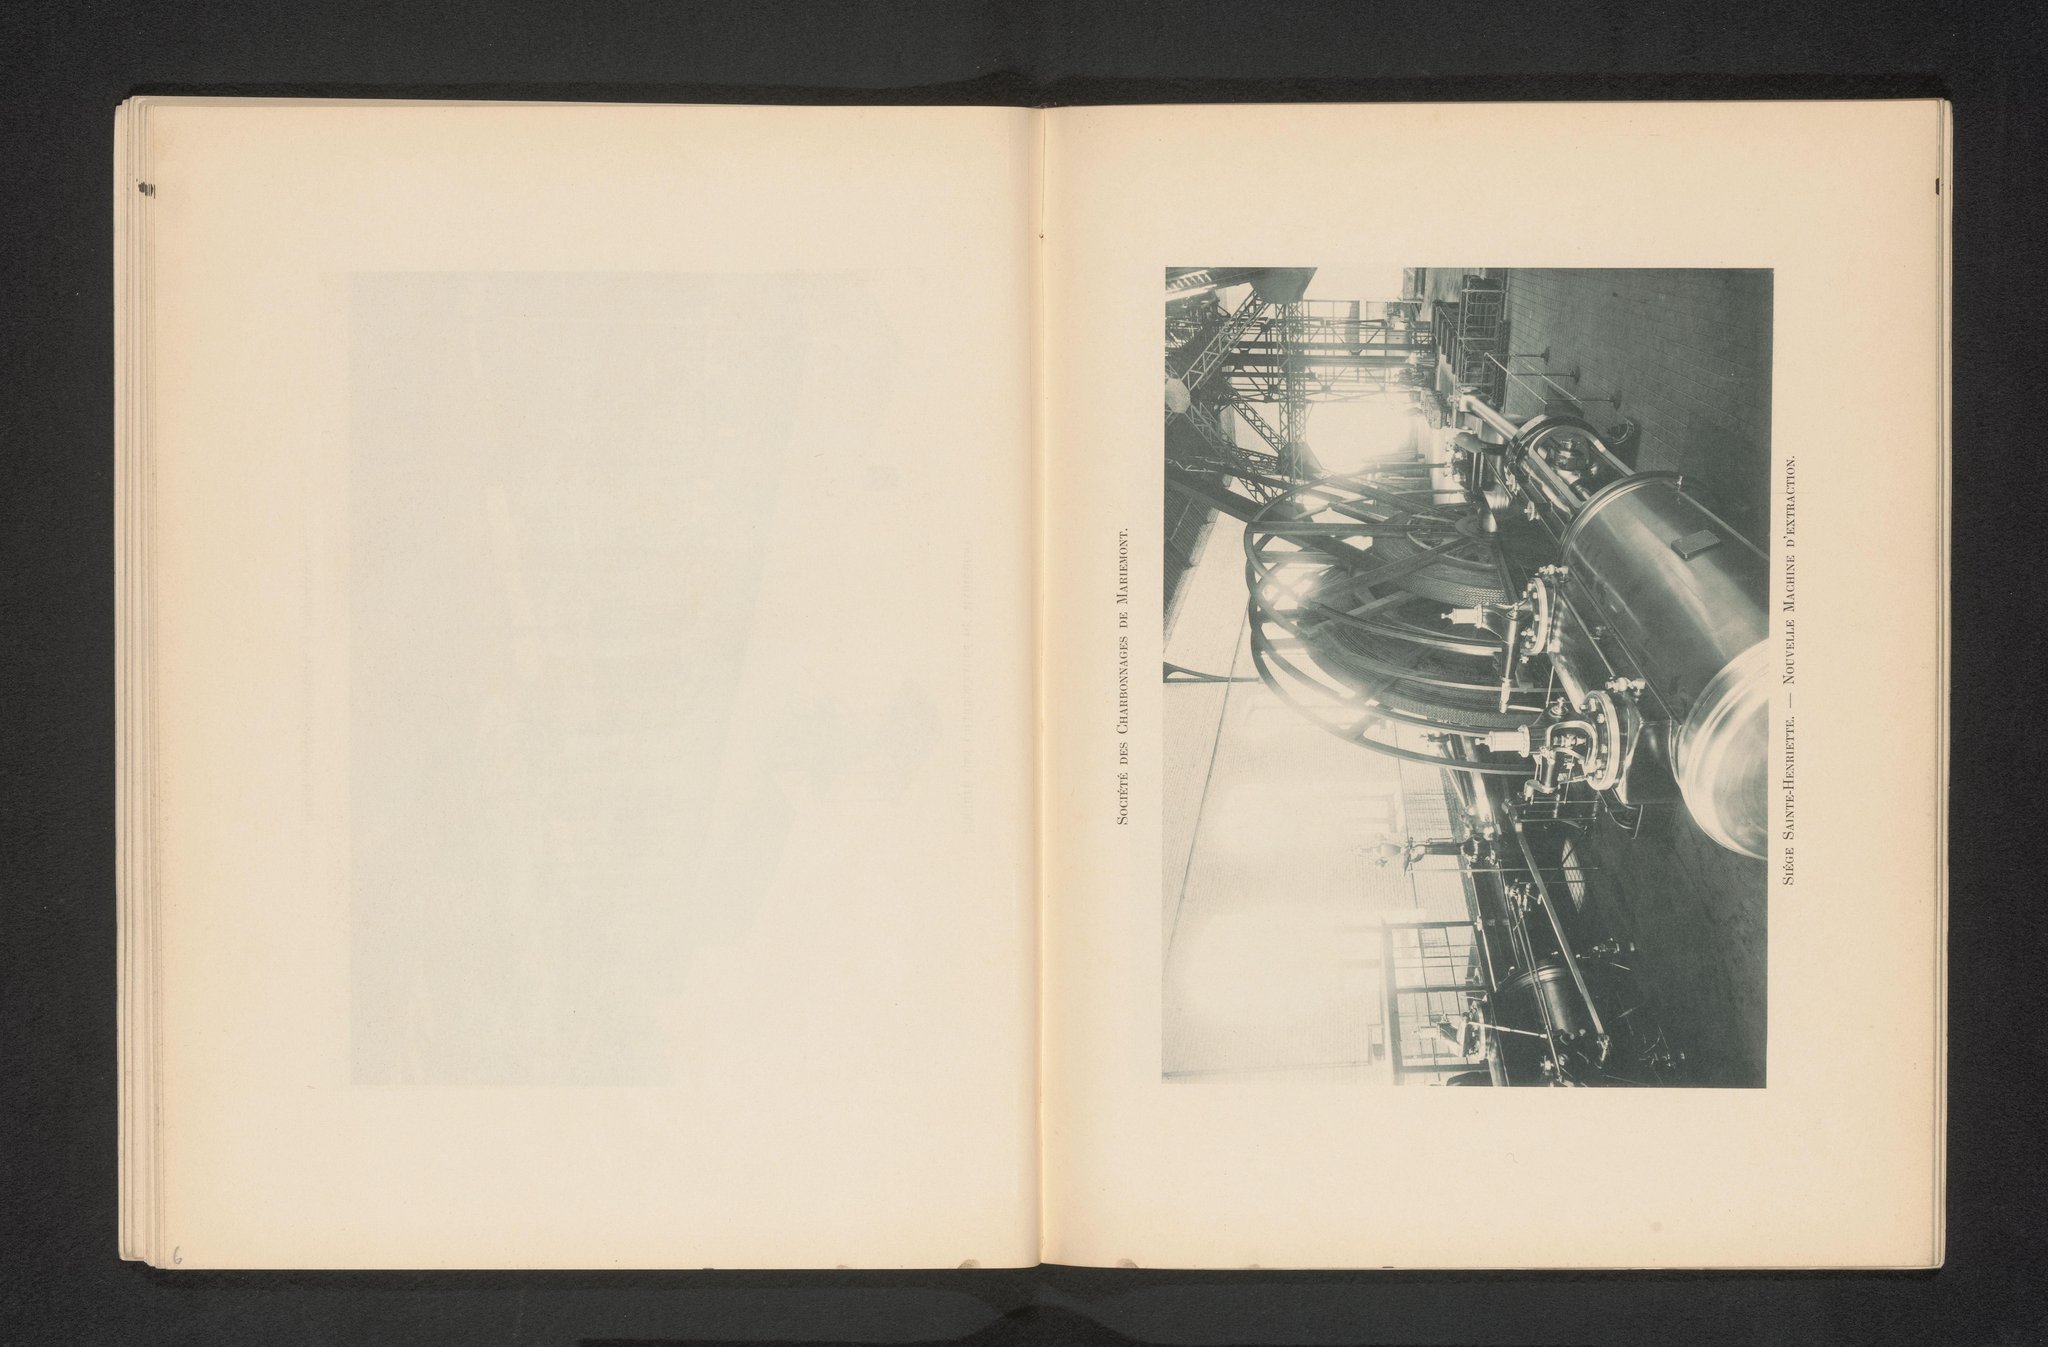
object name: page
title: Machine in de steenkolenmijn van Sante-Henriette te Morlanwelz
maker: Anonymous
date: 1895-1900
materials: paper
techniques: photograph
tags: machines; parts of machines; tools and appliances, mine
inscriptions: inscription: ‘Société des Charbonnages de Mariemont’